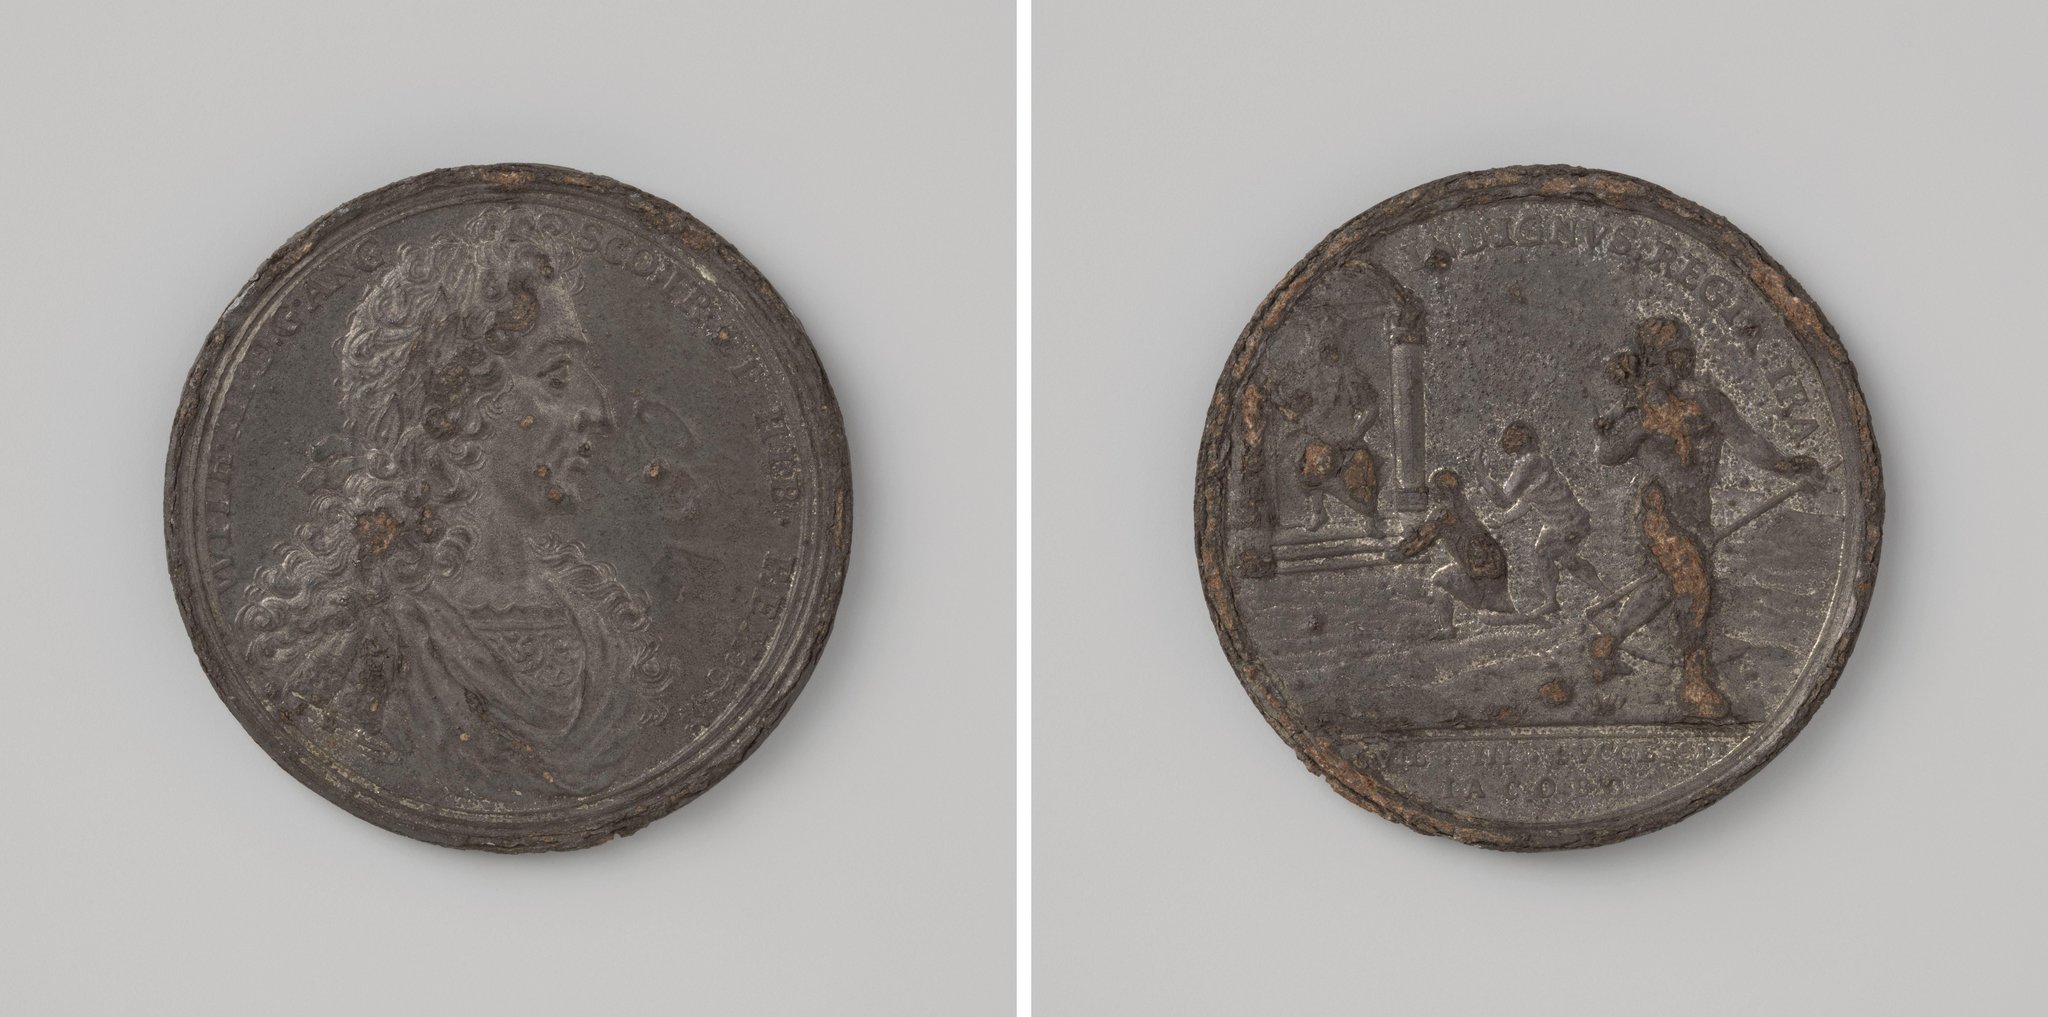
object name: history medal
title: Stadhouder Prins Willem III volgt de onwaardige Jacobus op als Koning van Engeland 1689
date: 1689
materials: tin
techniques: casting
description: Gegoten tinnen penning, op de voorzijde het gelauwerde borstbeeld van Willem III met omschrift, op de keerzijde een smekend echtpaar voor Jupiter's tempel terwijl rechts Saturnus zijn kind opeet, met omschrift en afsnedetekst.